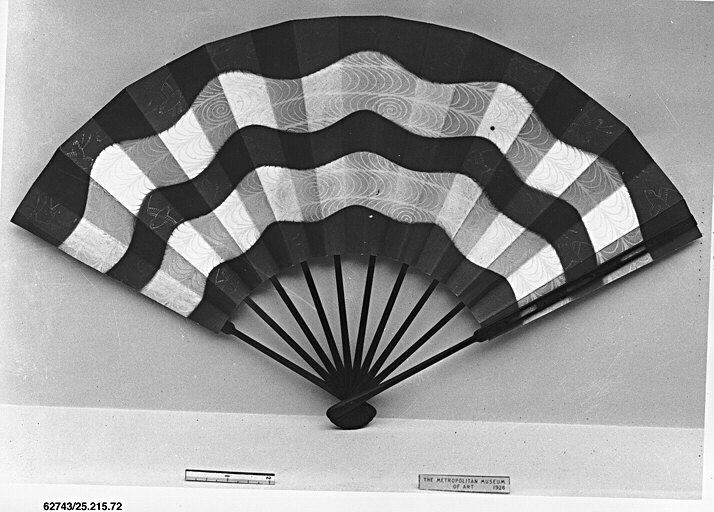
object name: folding fan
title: Fan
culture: japanese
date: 1901-2000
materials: metal, paint, paper